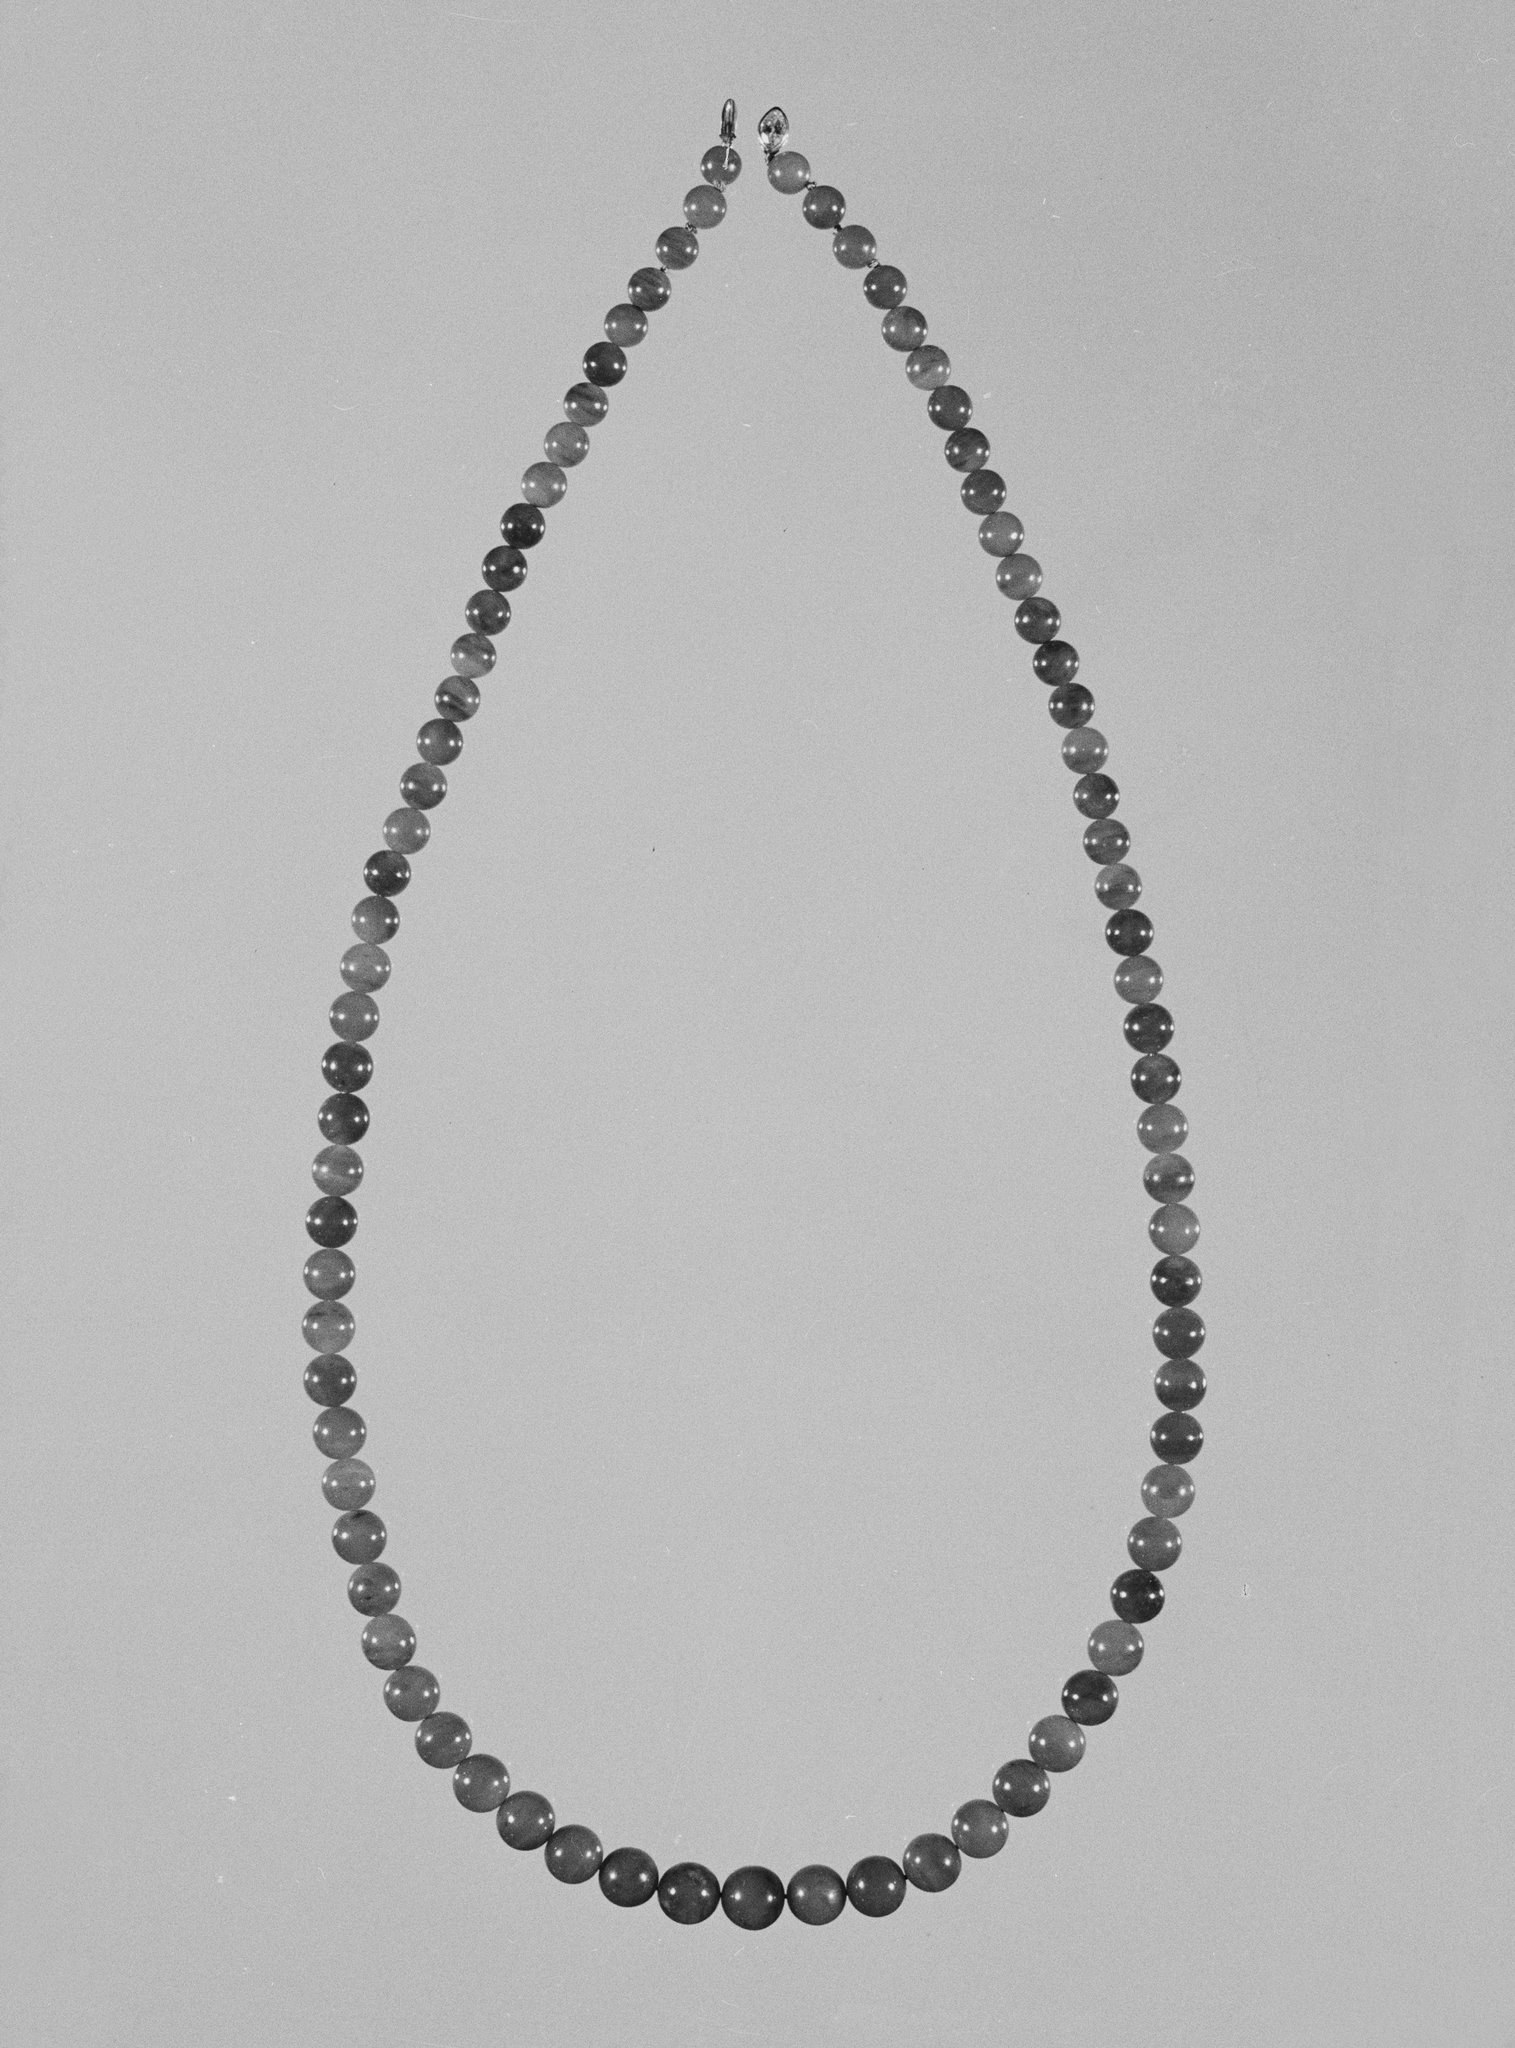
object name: necklace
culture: chinese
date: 1901-2000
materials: diamond, jade